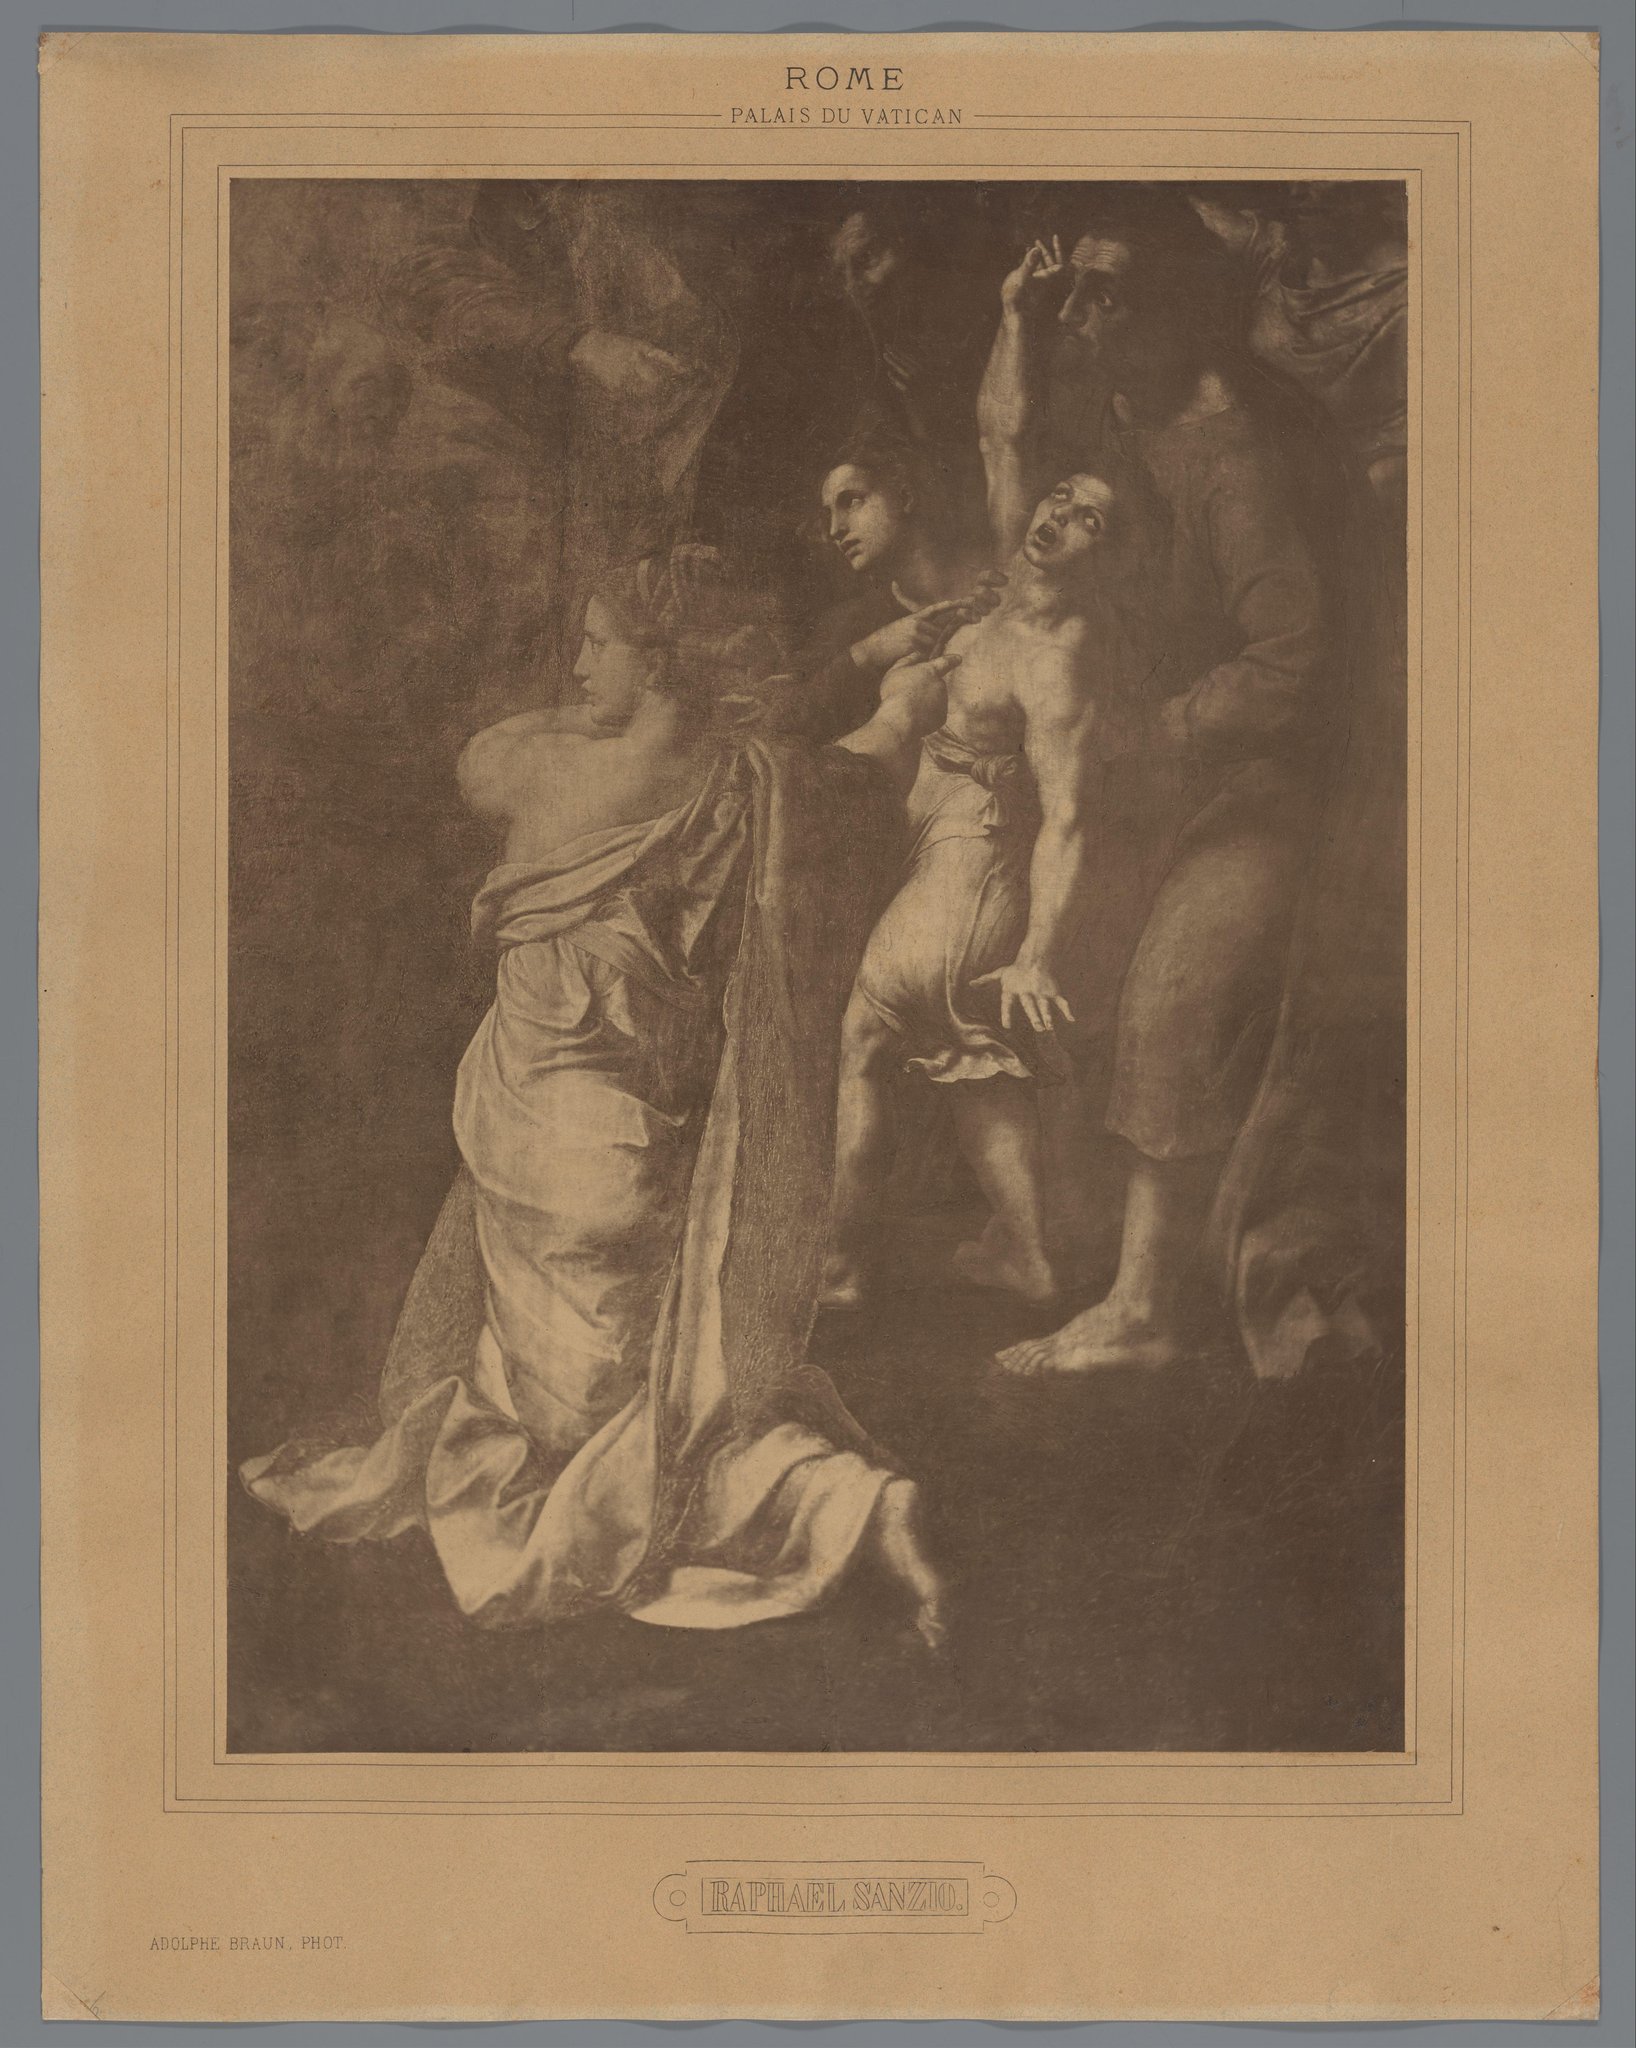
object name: photograph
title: Fotoreproductie van een schilderij van Rafaël (coll. Vaticaanse Musea)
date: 1880-1900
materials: cardboard, paper, photographic support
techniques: carbon print